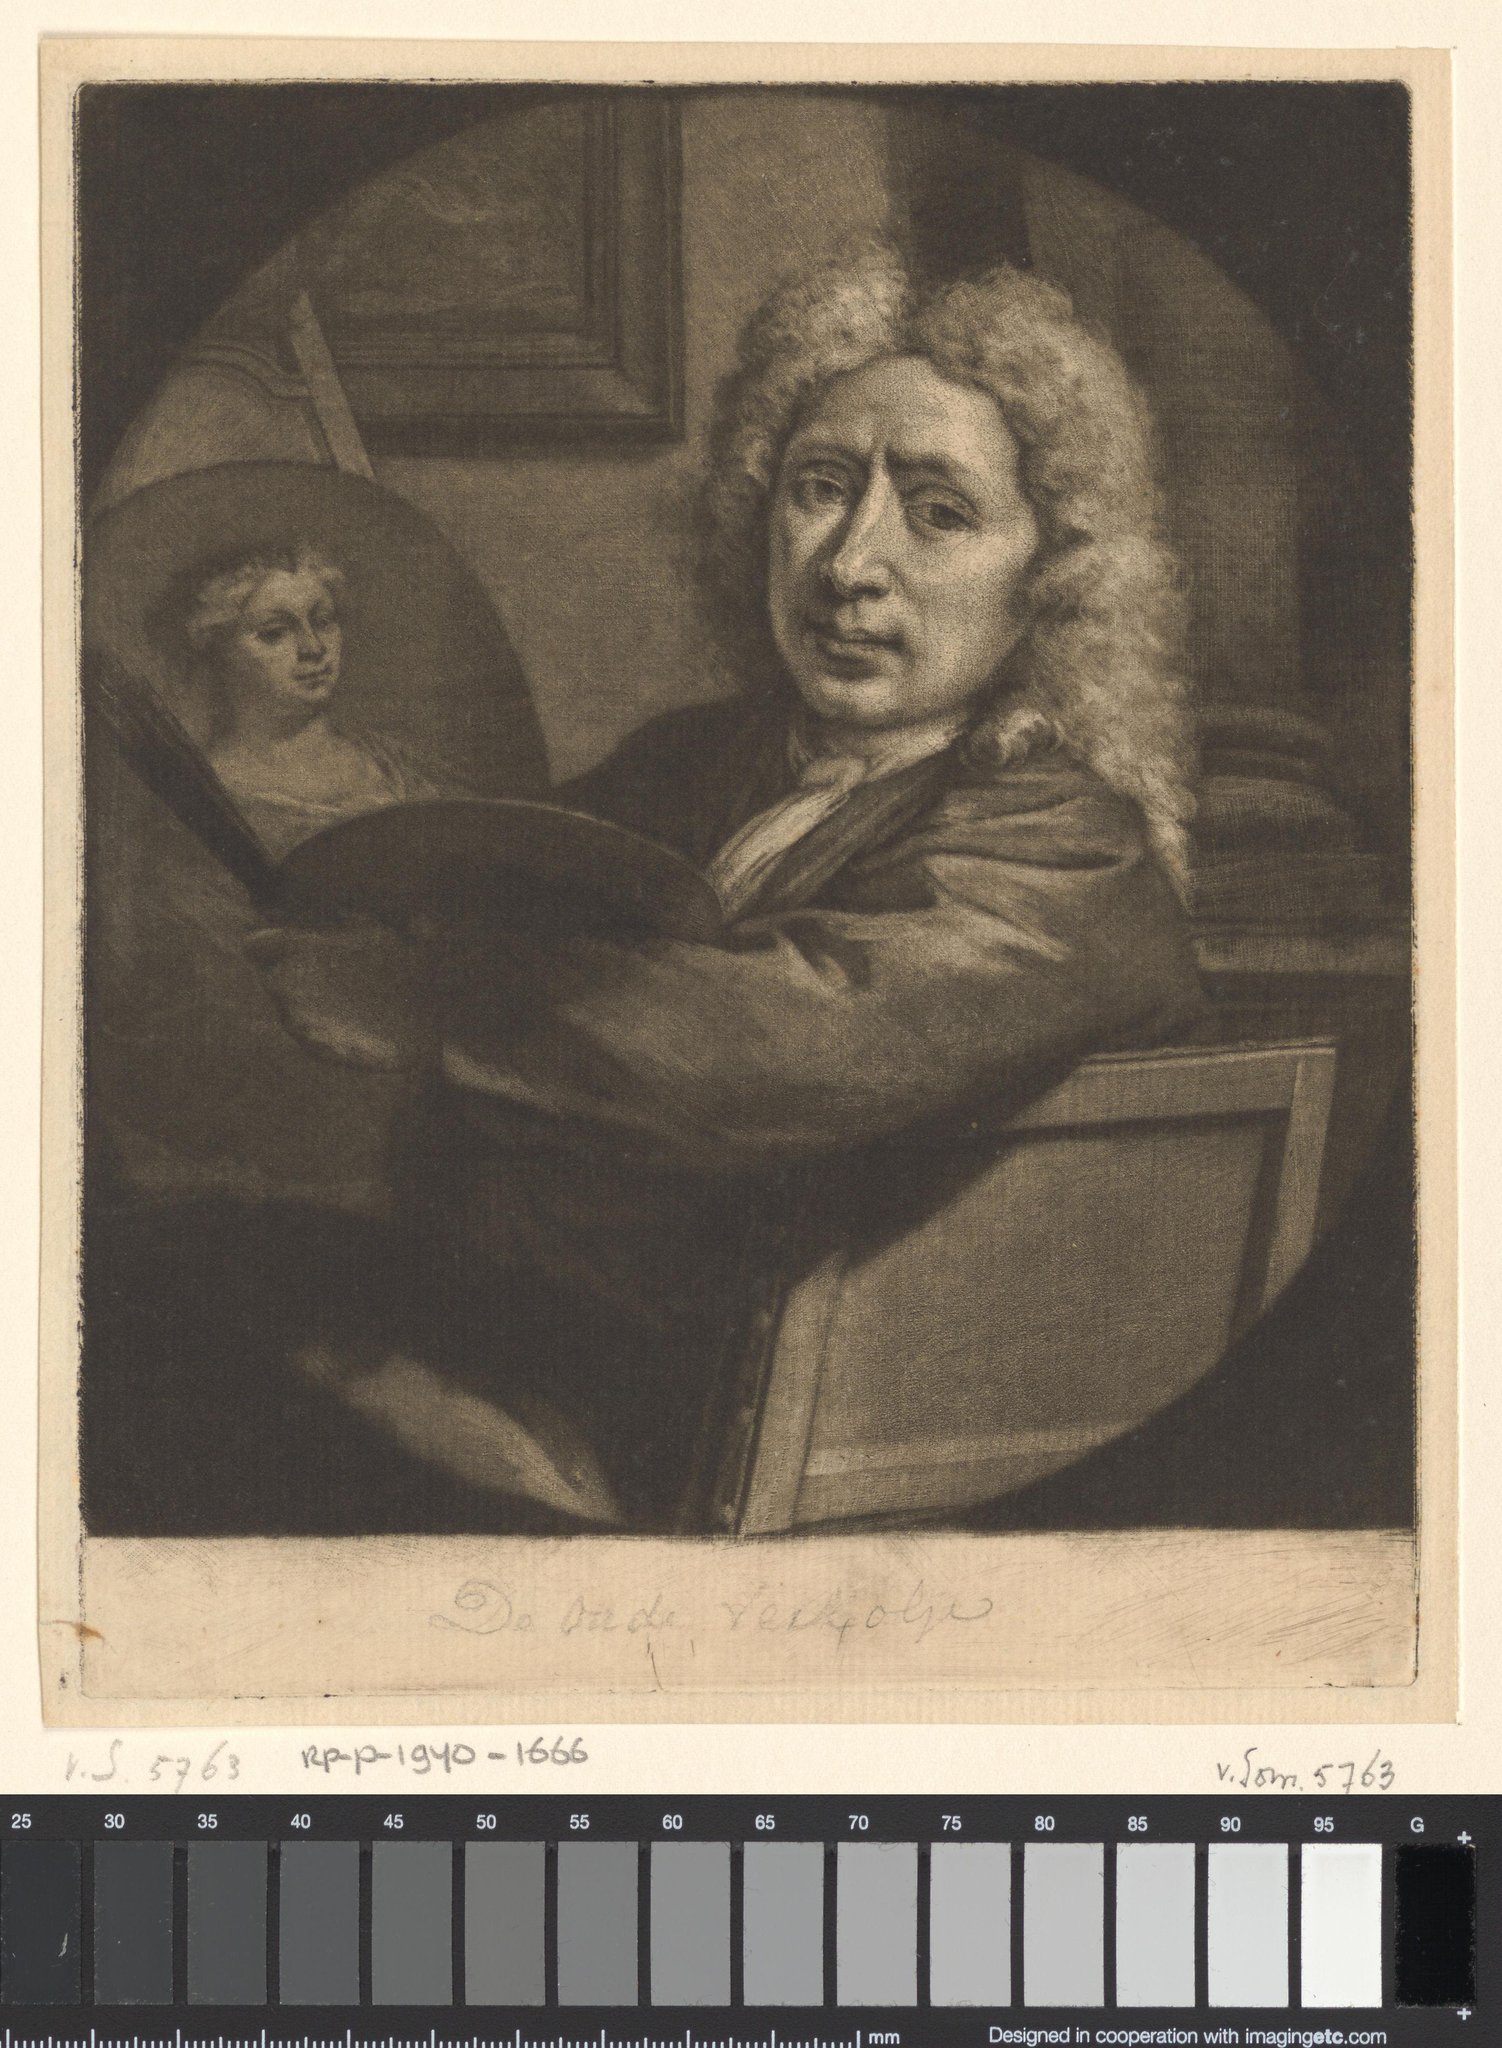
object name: print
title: Portret van Johannes Verkolje met het portret van zijn vrouw Judith Verheul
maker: nicolaas verkolje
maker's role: draughtsman, painter, print maker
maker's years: 1673-1746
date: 1683-1746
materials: paper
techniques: mezzotint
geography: northern netherlands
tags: amsterdam, delft, painter, print maker, draughtsman, jan verkolje (i), drawing, historical persons - bb - woman, historical persons, portrait, self-portrait of painter, tools, implements of painter, picture, painting, portrait, self-portrait of graphic artist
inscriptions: collector's mark: Lugt 2760, title: ‘De oude Verkolje’, collector's mark: Lugt 2166